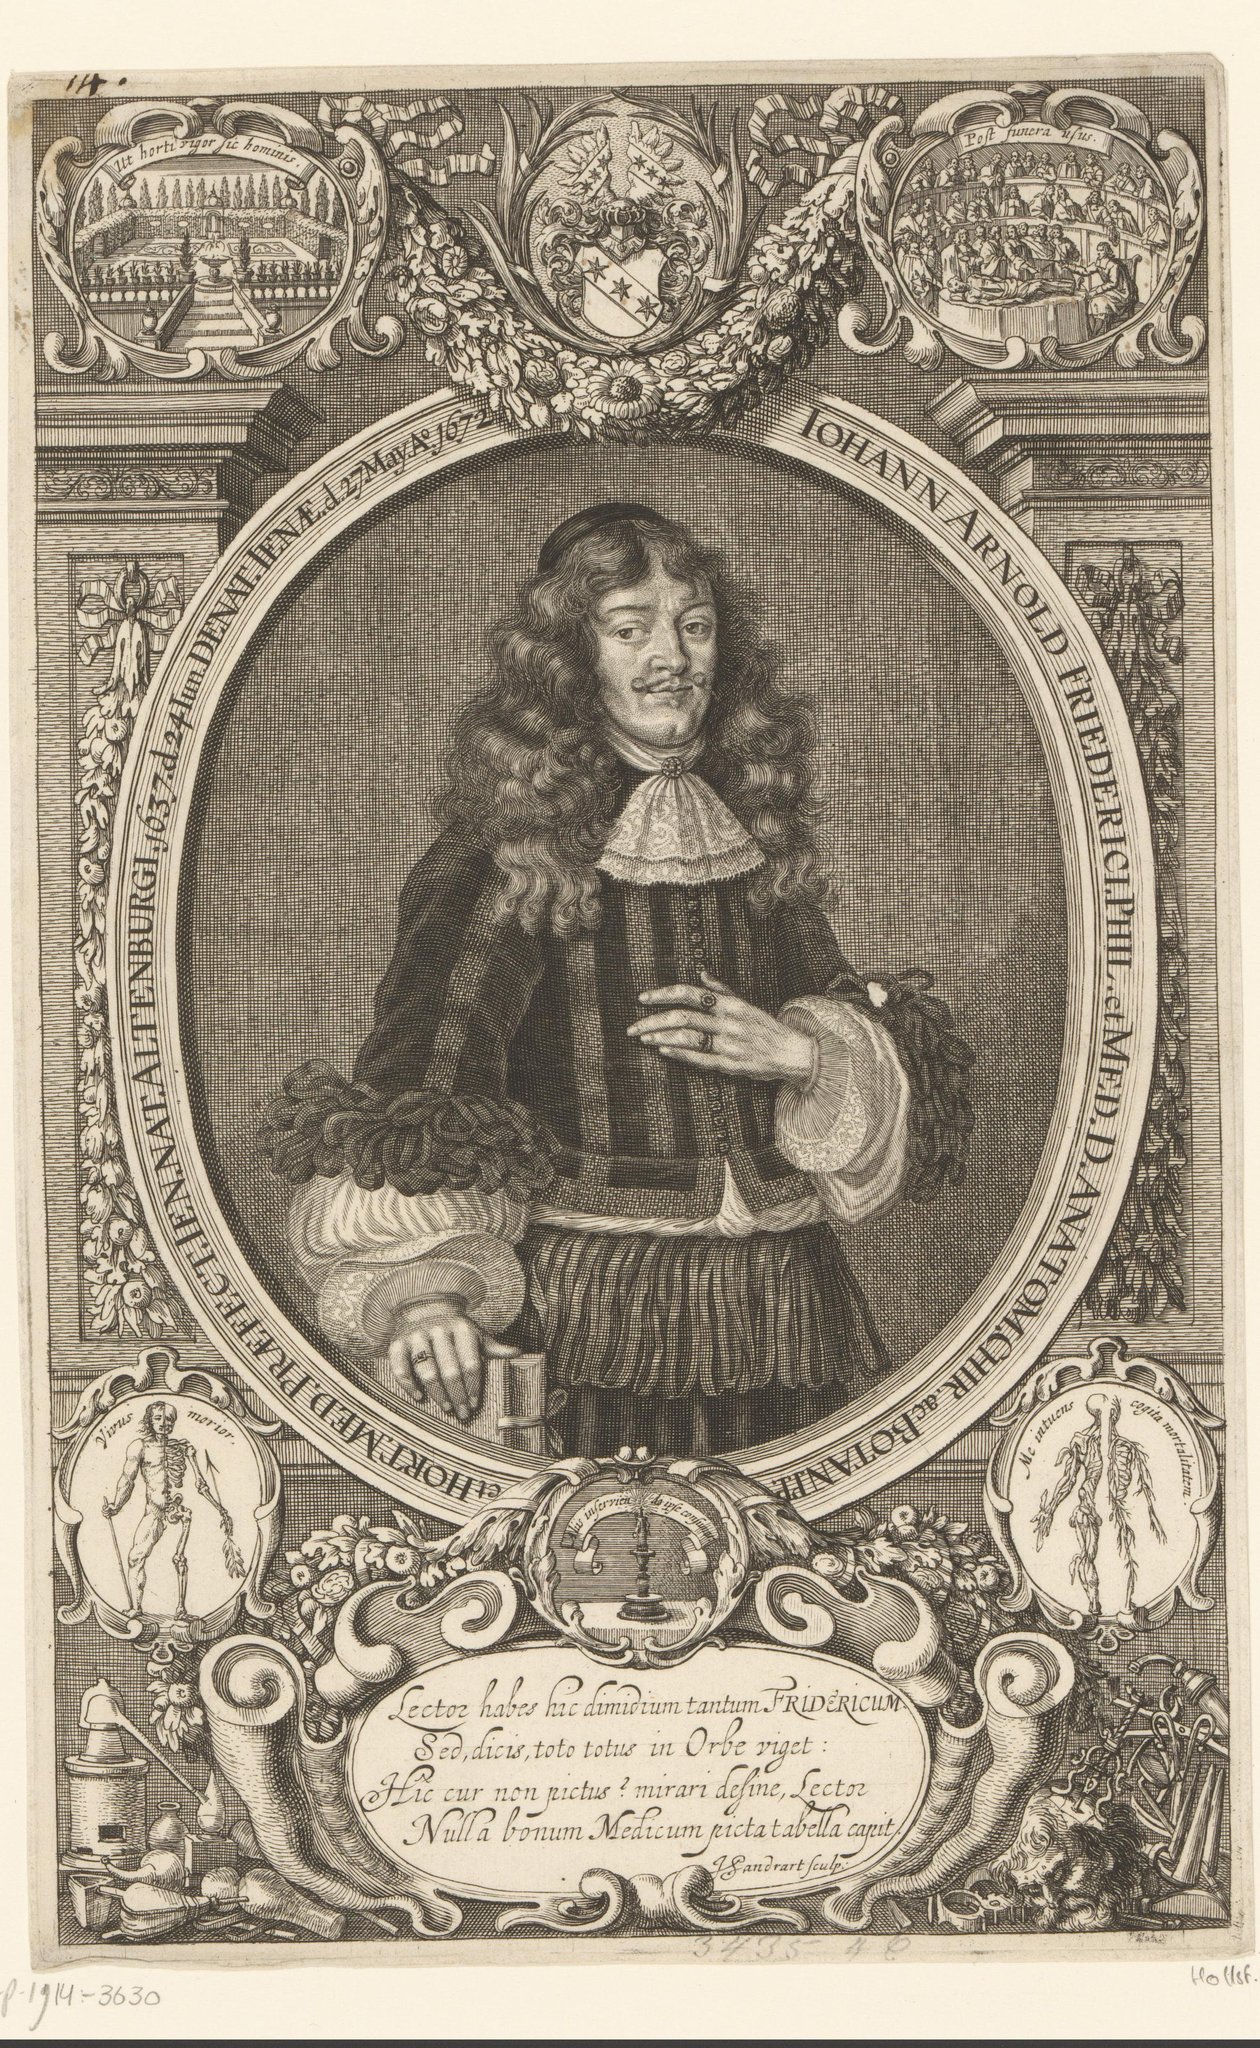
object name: print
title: Portret van Johann Arnold Friderici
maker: jakob von sandrart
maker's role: print maker, publisher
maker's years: 1630-1708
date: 1672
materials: paper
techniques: engraving, etching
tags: historical persons, armorial bearing, heraldry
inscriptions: collector's mark: Lugt 2228